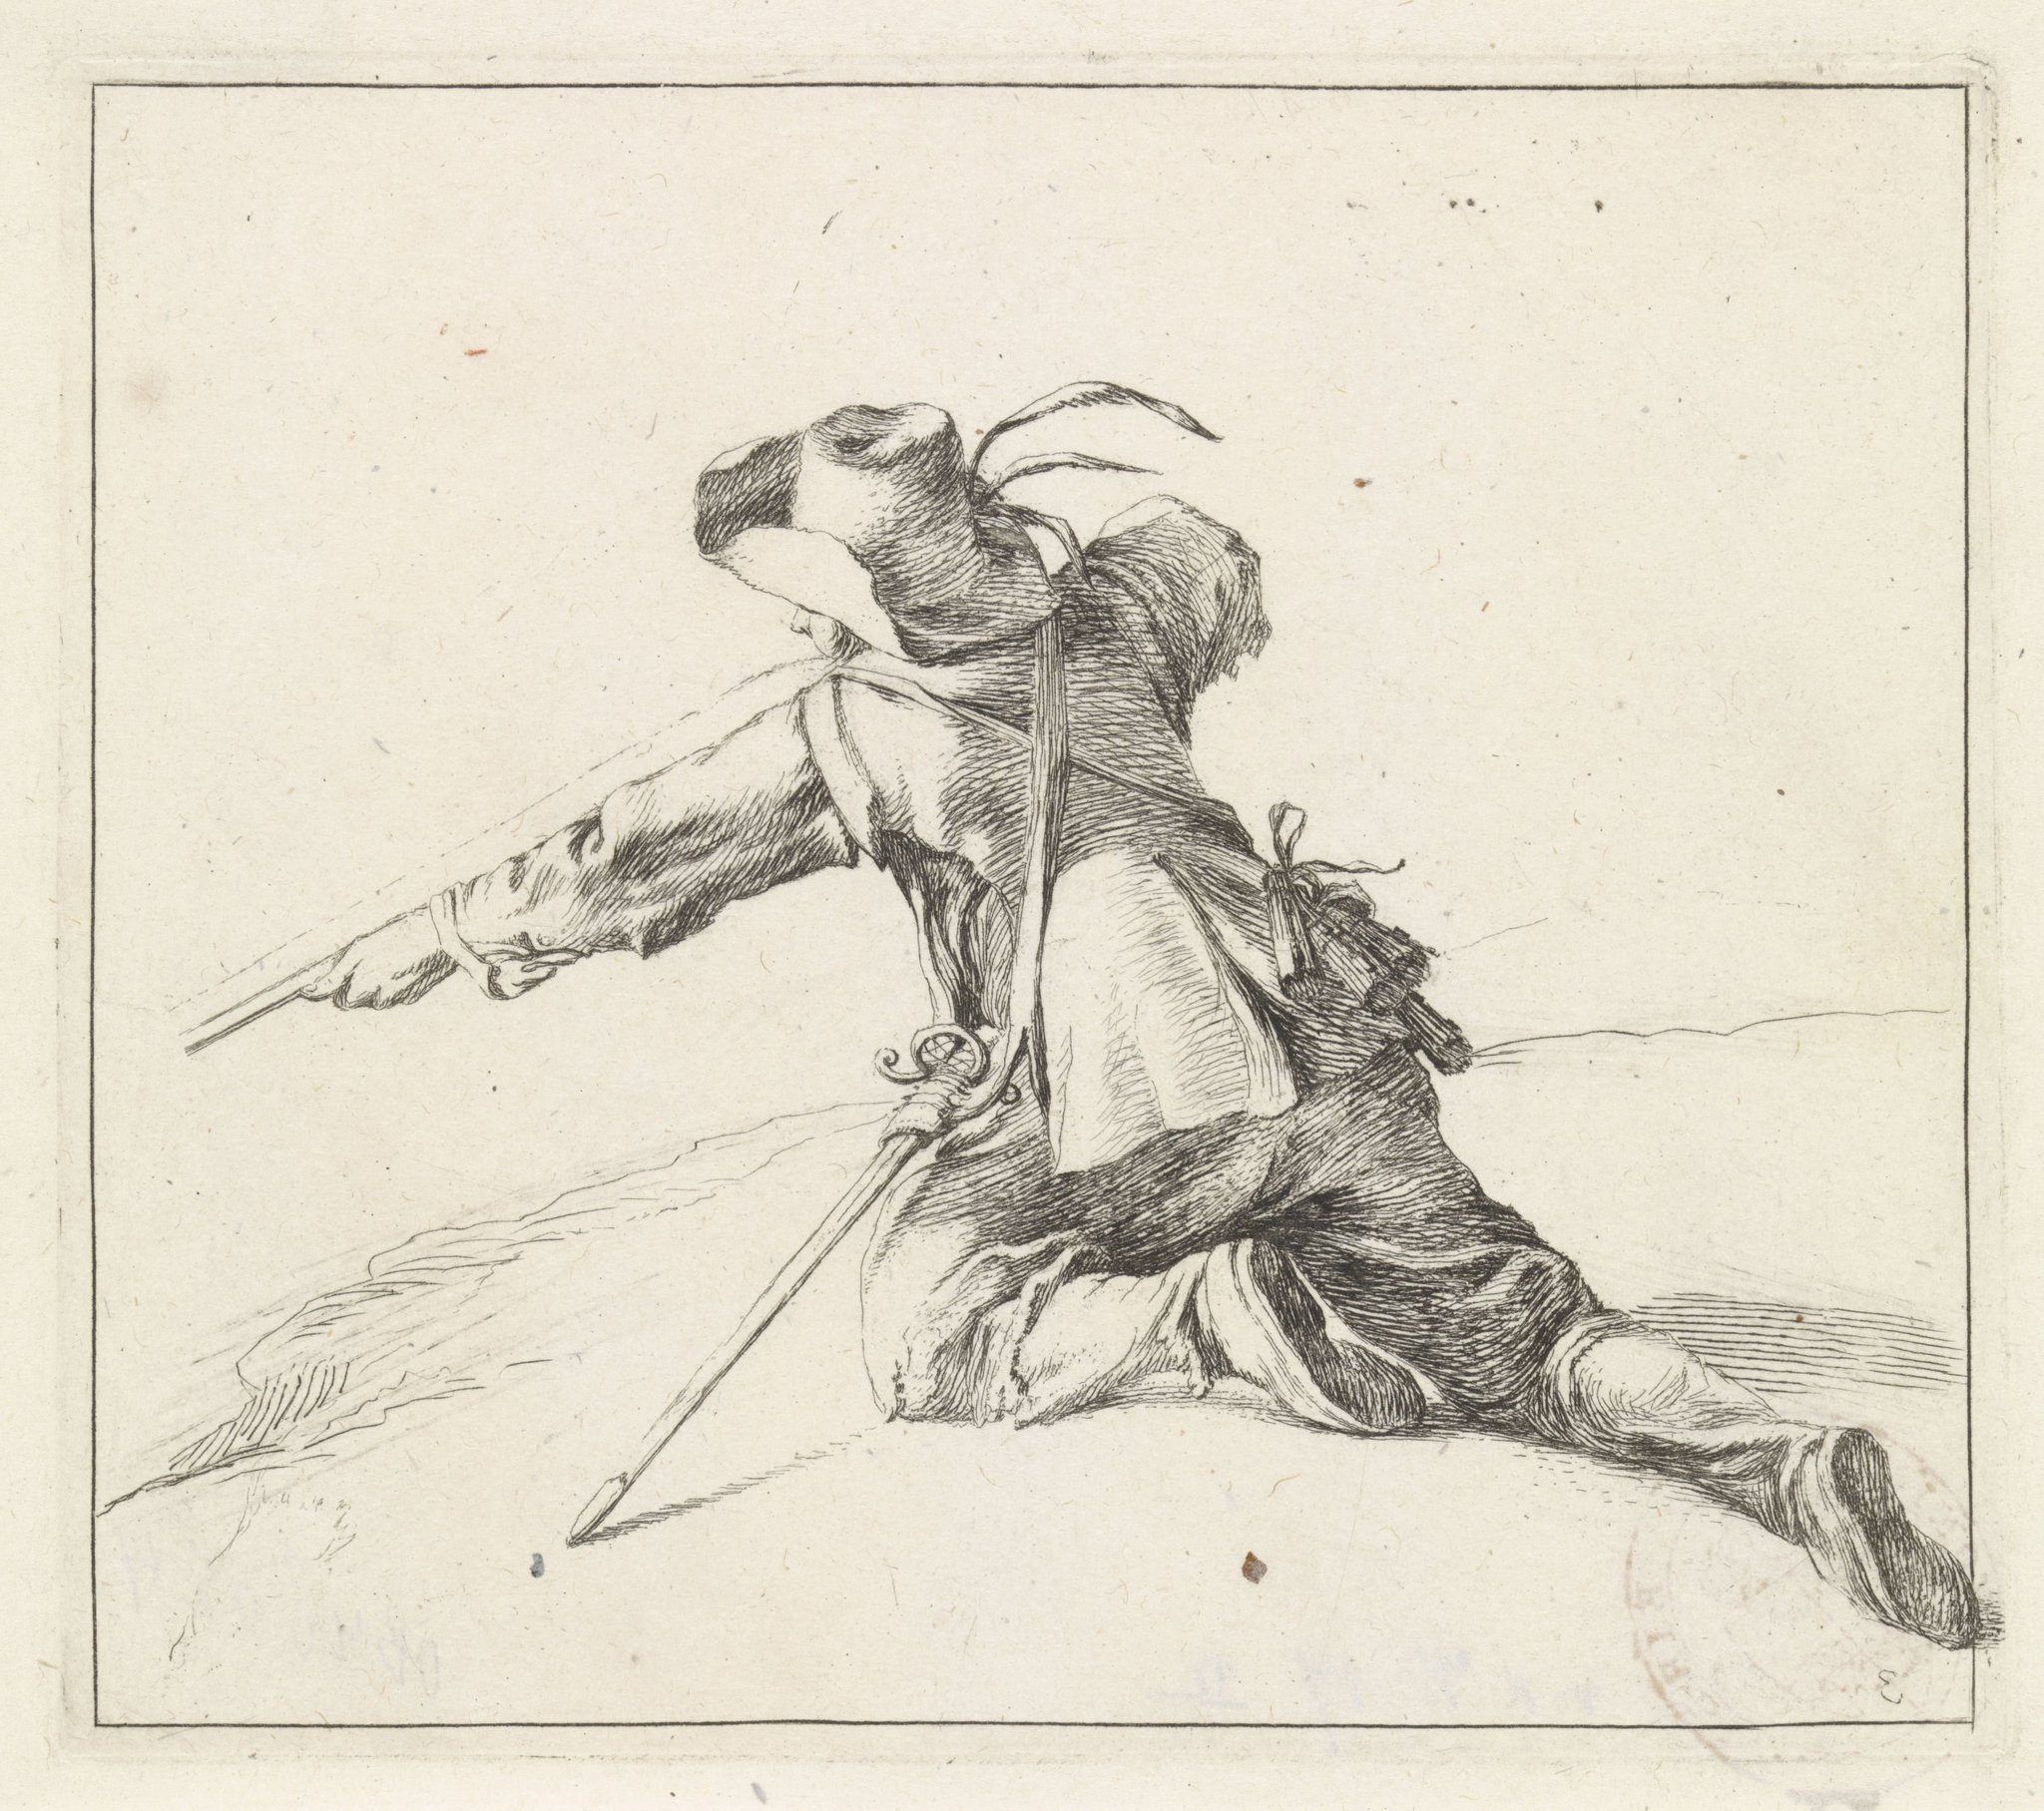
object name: print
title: Soldaten en paarden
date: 1710-1717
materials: paper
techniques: etching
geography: amsterdam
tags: the soldier; the soldier's life (+ weapons), handling of weapons ~ military training, firearms: rifle, kneeling on both knees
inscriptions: collector's mark: Lugt 240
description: Geknielde soldaat met geweer naar links, op de rug gezien. Over zijn schouder een zwaard en op zijn hoofd een hoed met veren. Derde prent uit een serie van twaalf prenten met voorstellingen van soldaten en paarden.